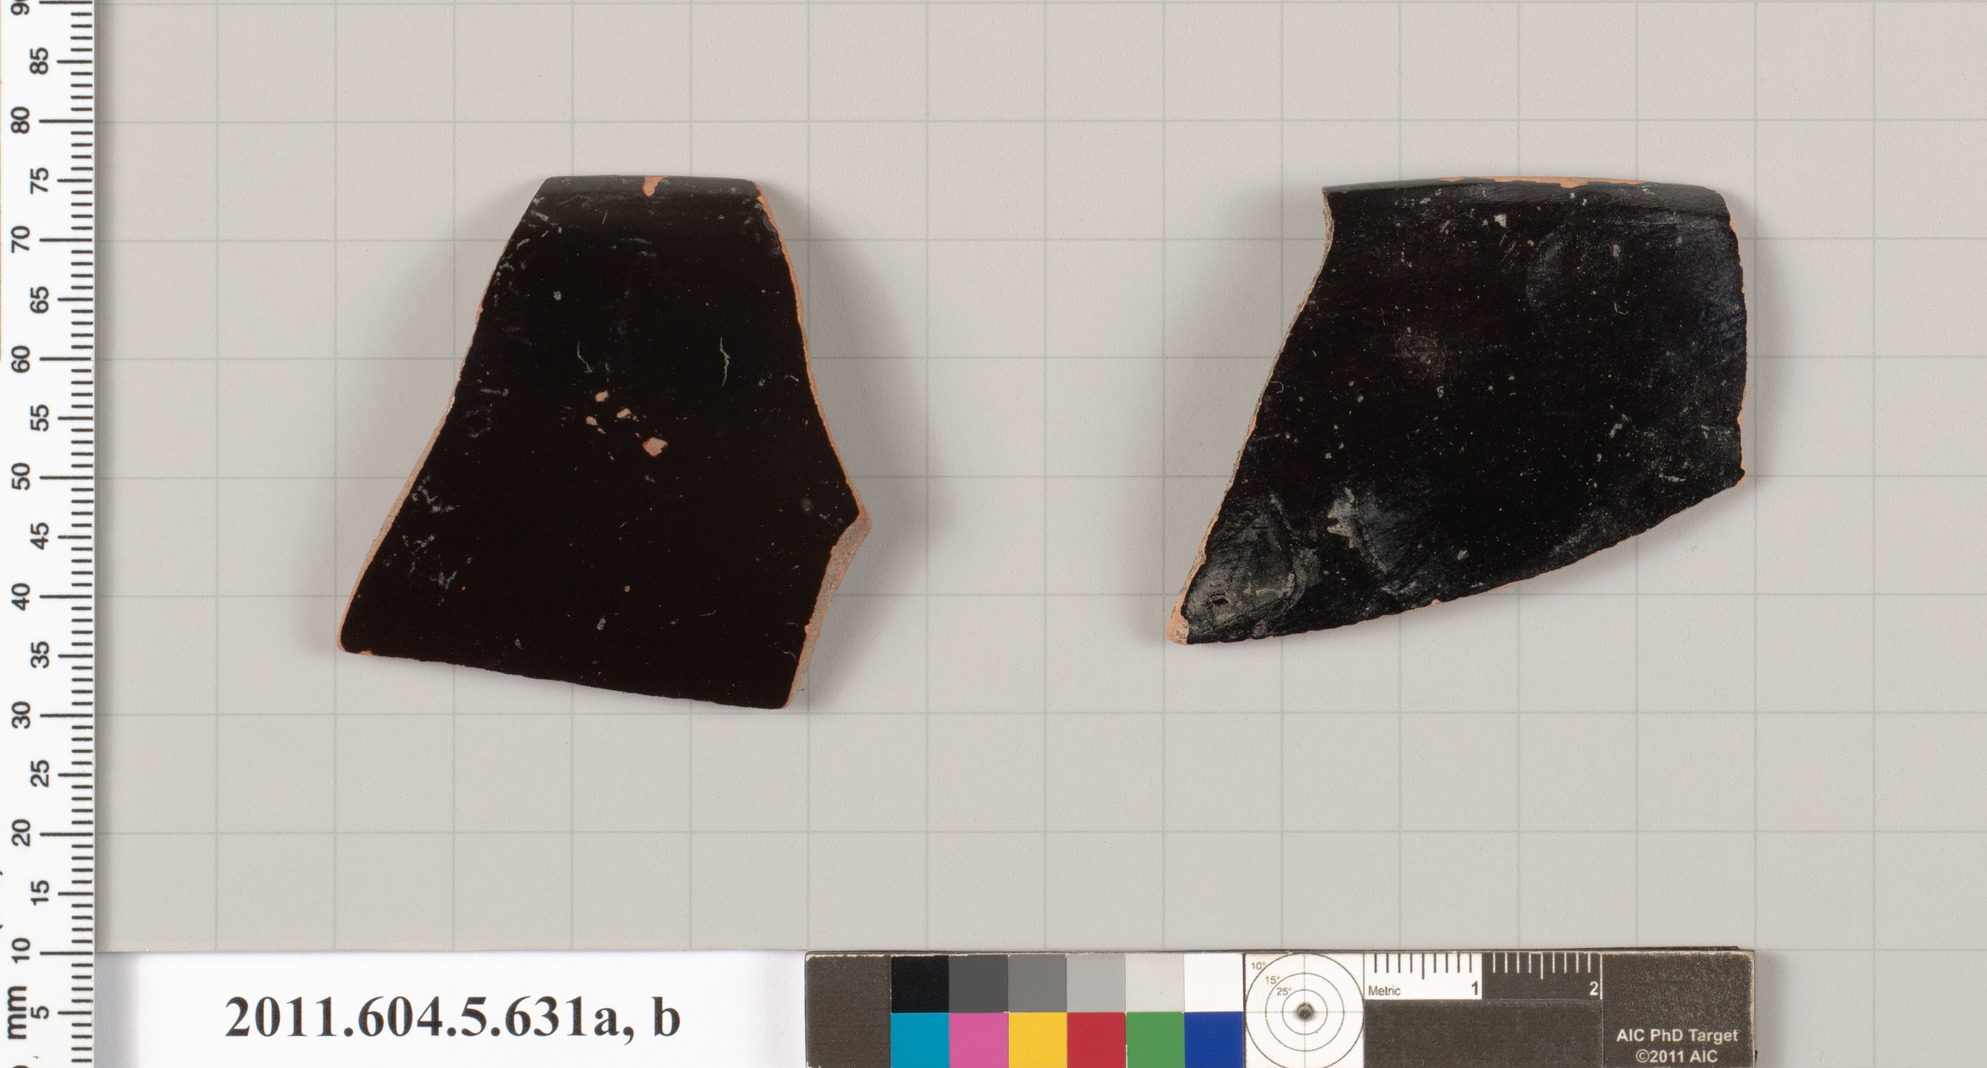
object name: kylix fragment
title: Terracotta rim fragments of kylikes (drinking cups)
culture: greek, attic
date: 600-401 BCE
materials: terracotta